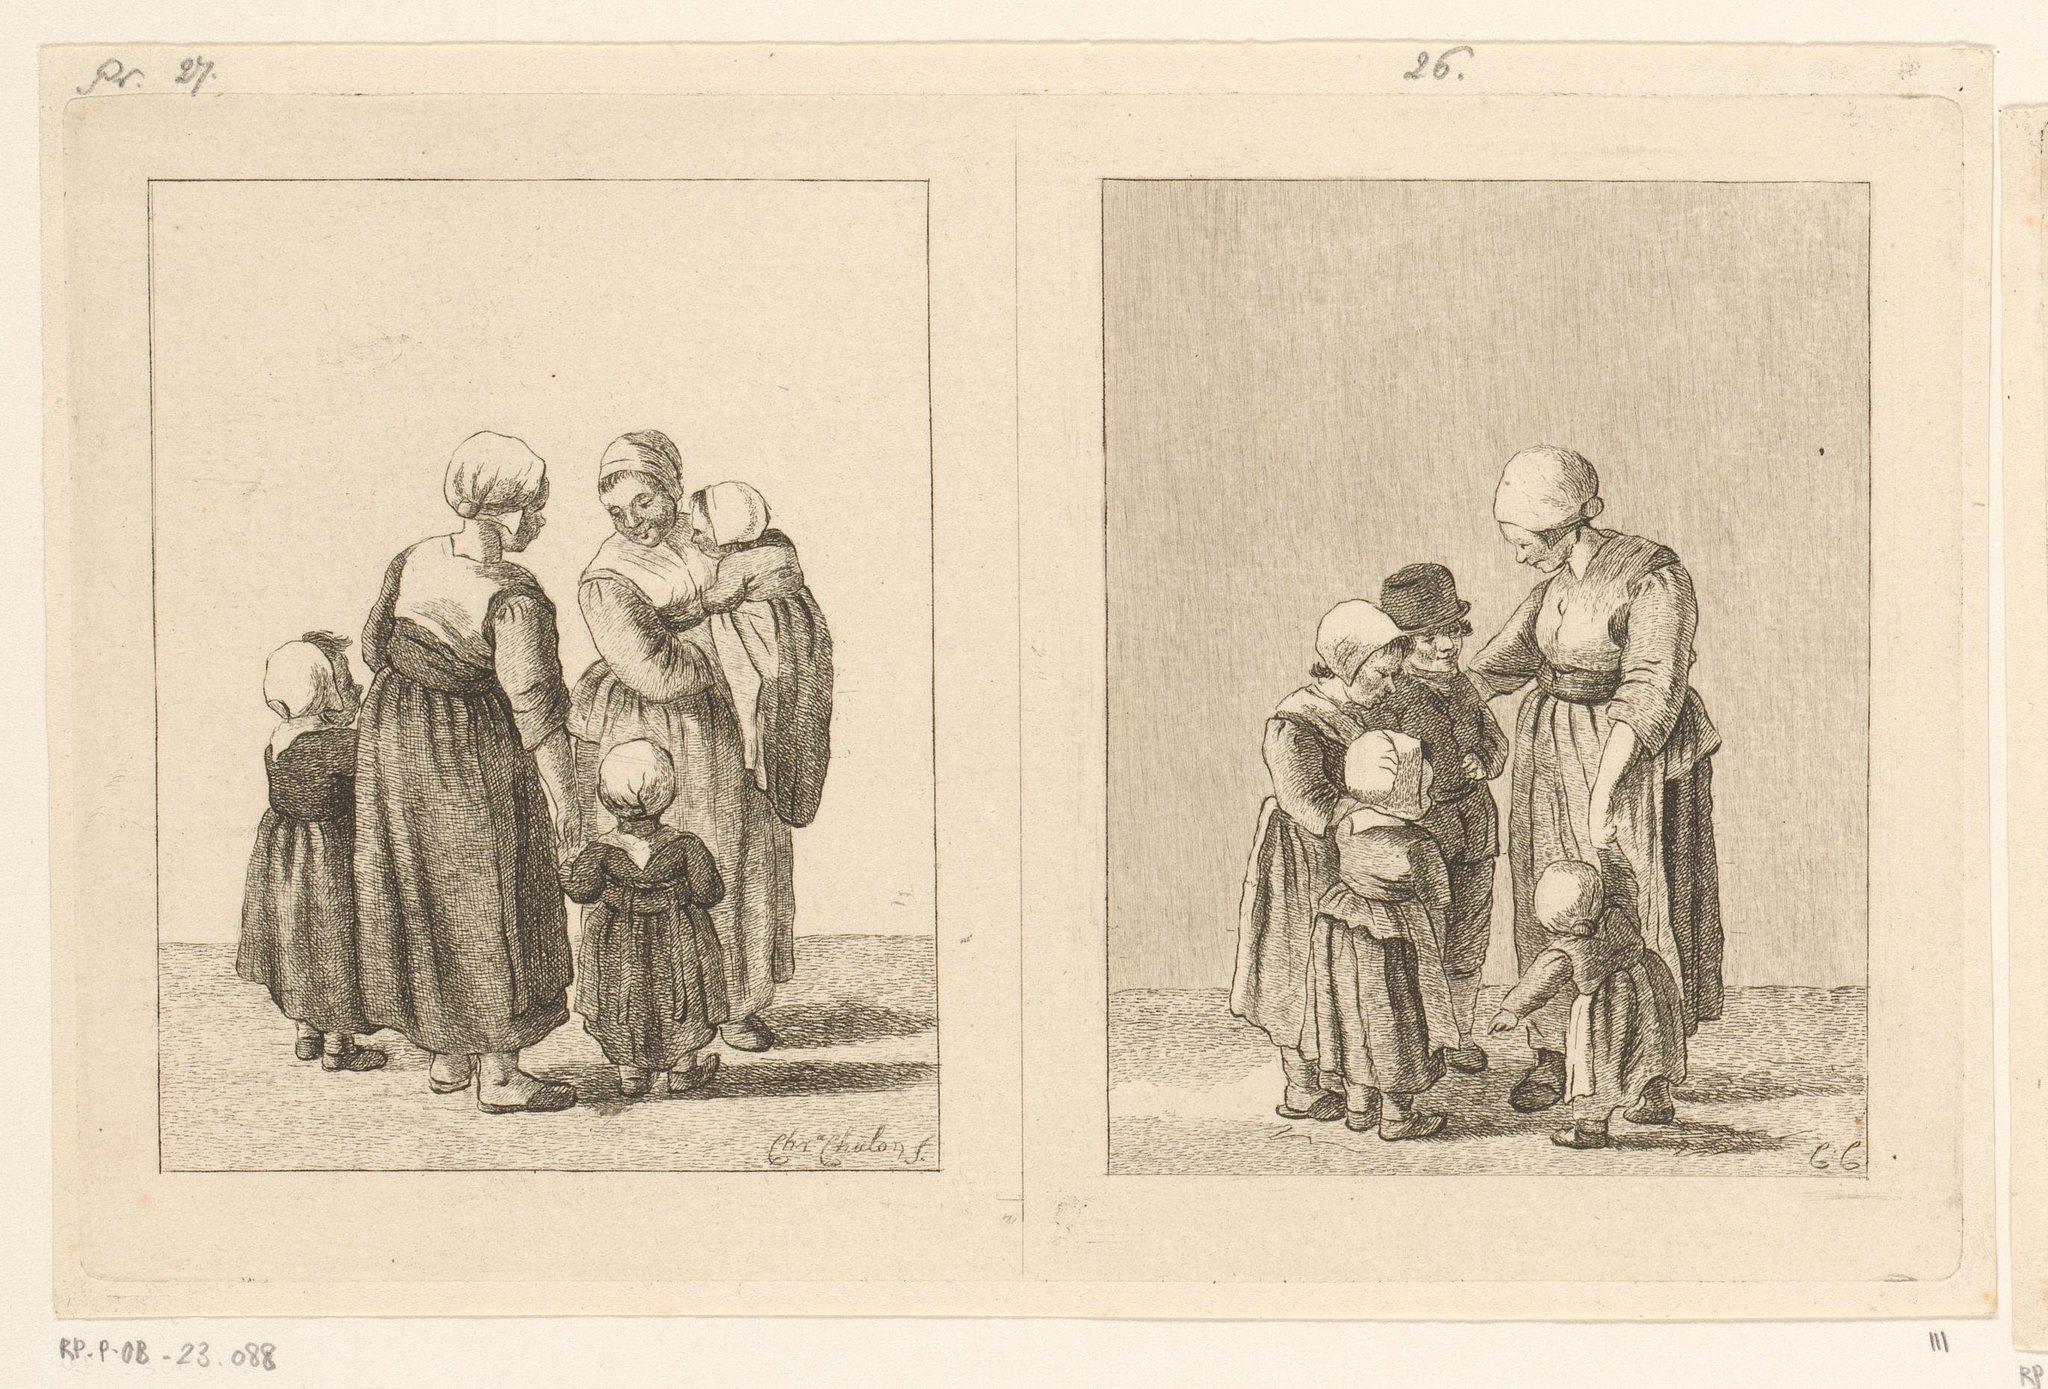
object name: print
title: Twee voorstellingen van kinderen en hun moeder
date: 1779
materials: paper, pencil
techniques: etching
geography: leiden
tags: mother and baby or young child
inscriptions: collector's mark: Lugt 240, number: ‘Pr. 27. 26.’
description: Twee voorstellingen van kinderen en hun moeder: links twee moeders in gesprek en rechts een moeder met vier kinderen.